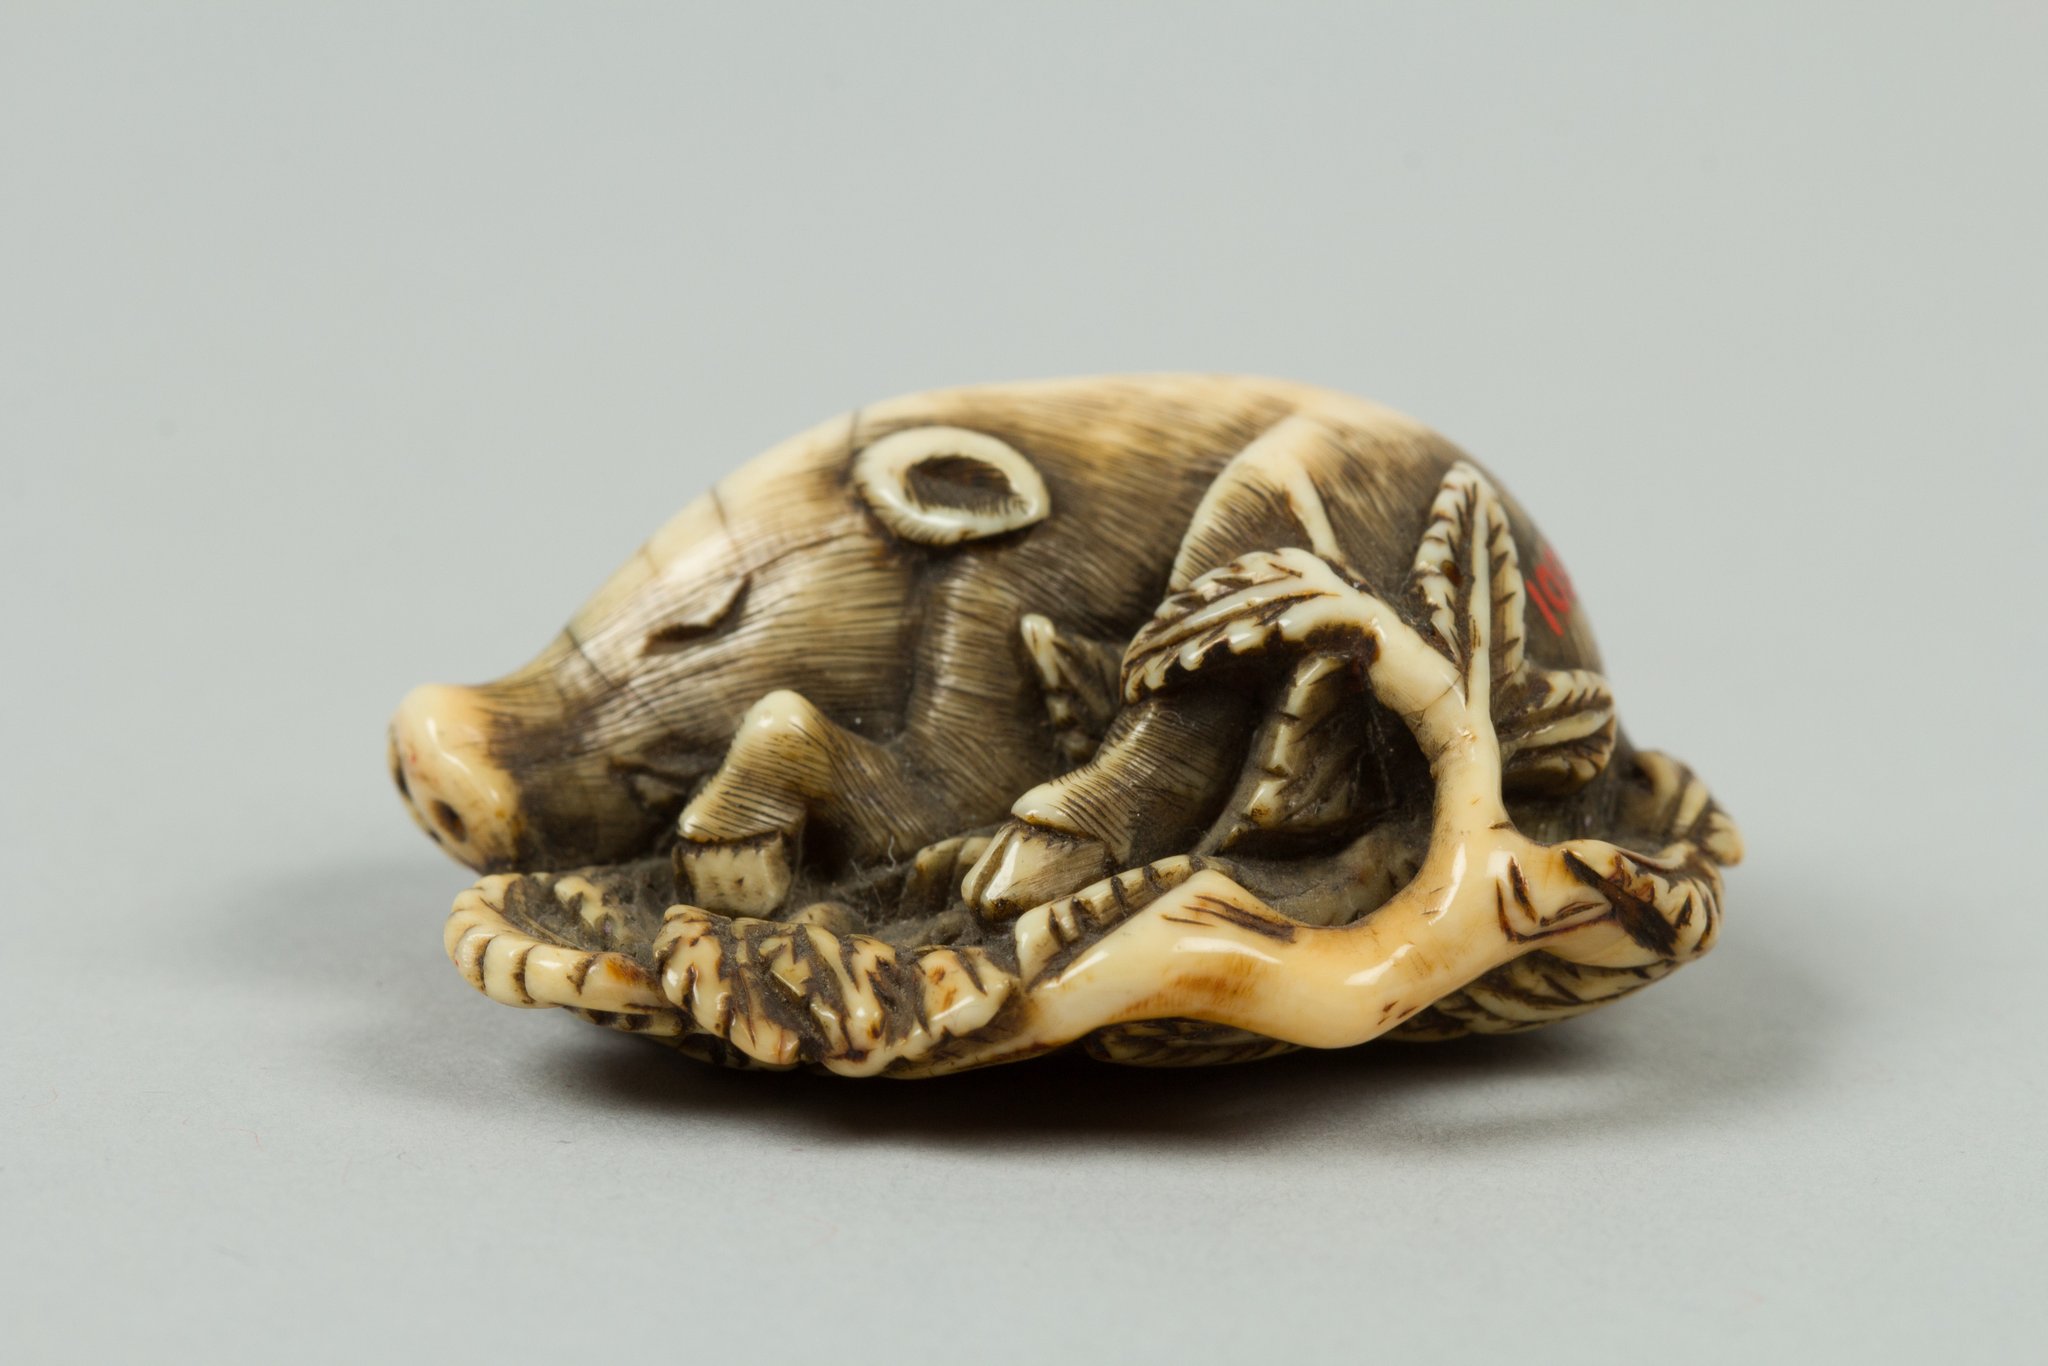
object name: netsuke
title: Netsuke of Sleeping Boar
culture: japanese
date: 1801-1900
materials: ivory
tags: boars